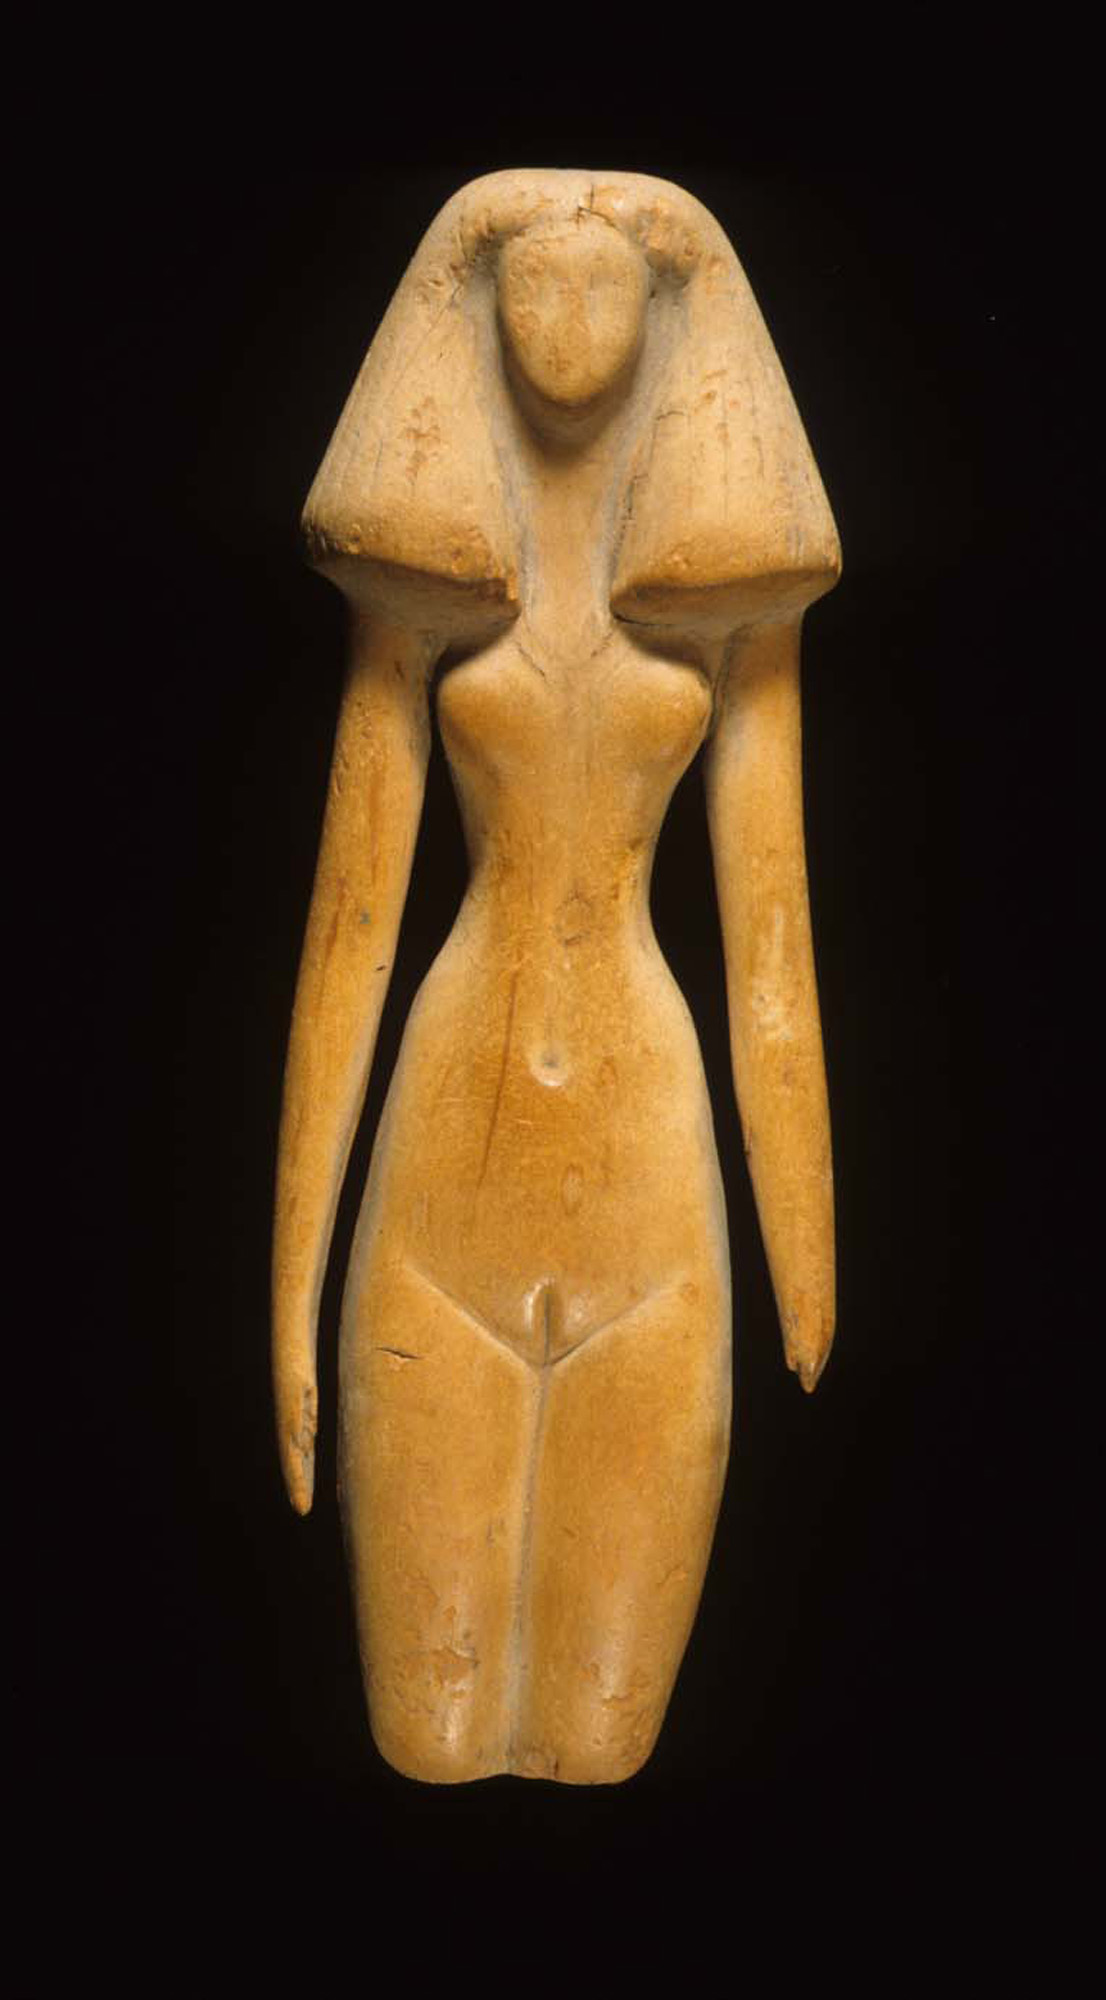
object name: statuette, female nude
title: Female figure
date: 1991-1802 BCE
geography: egypt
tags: women